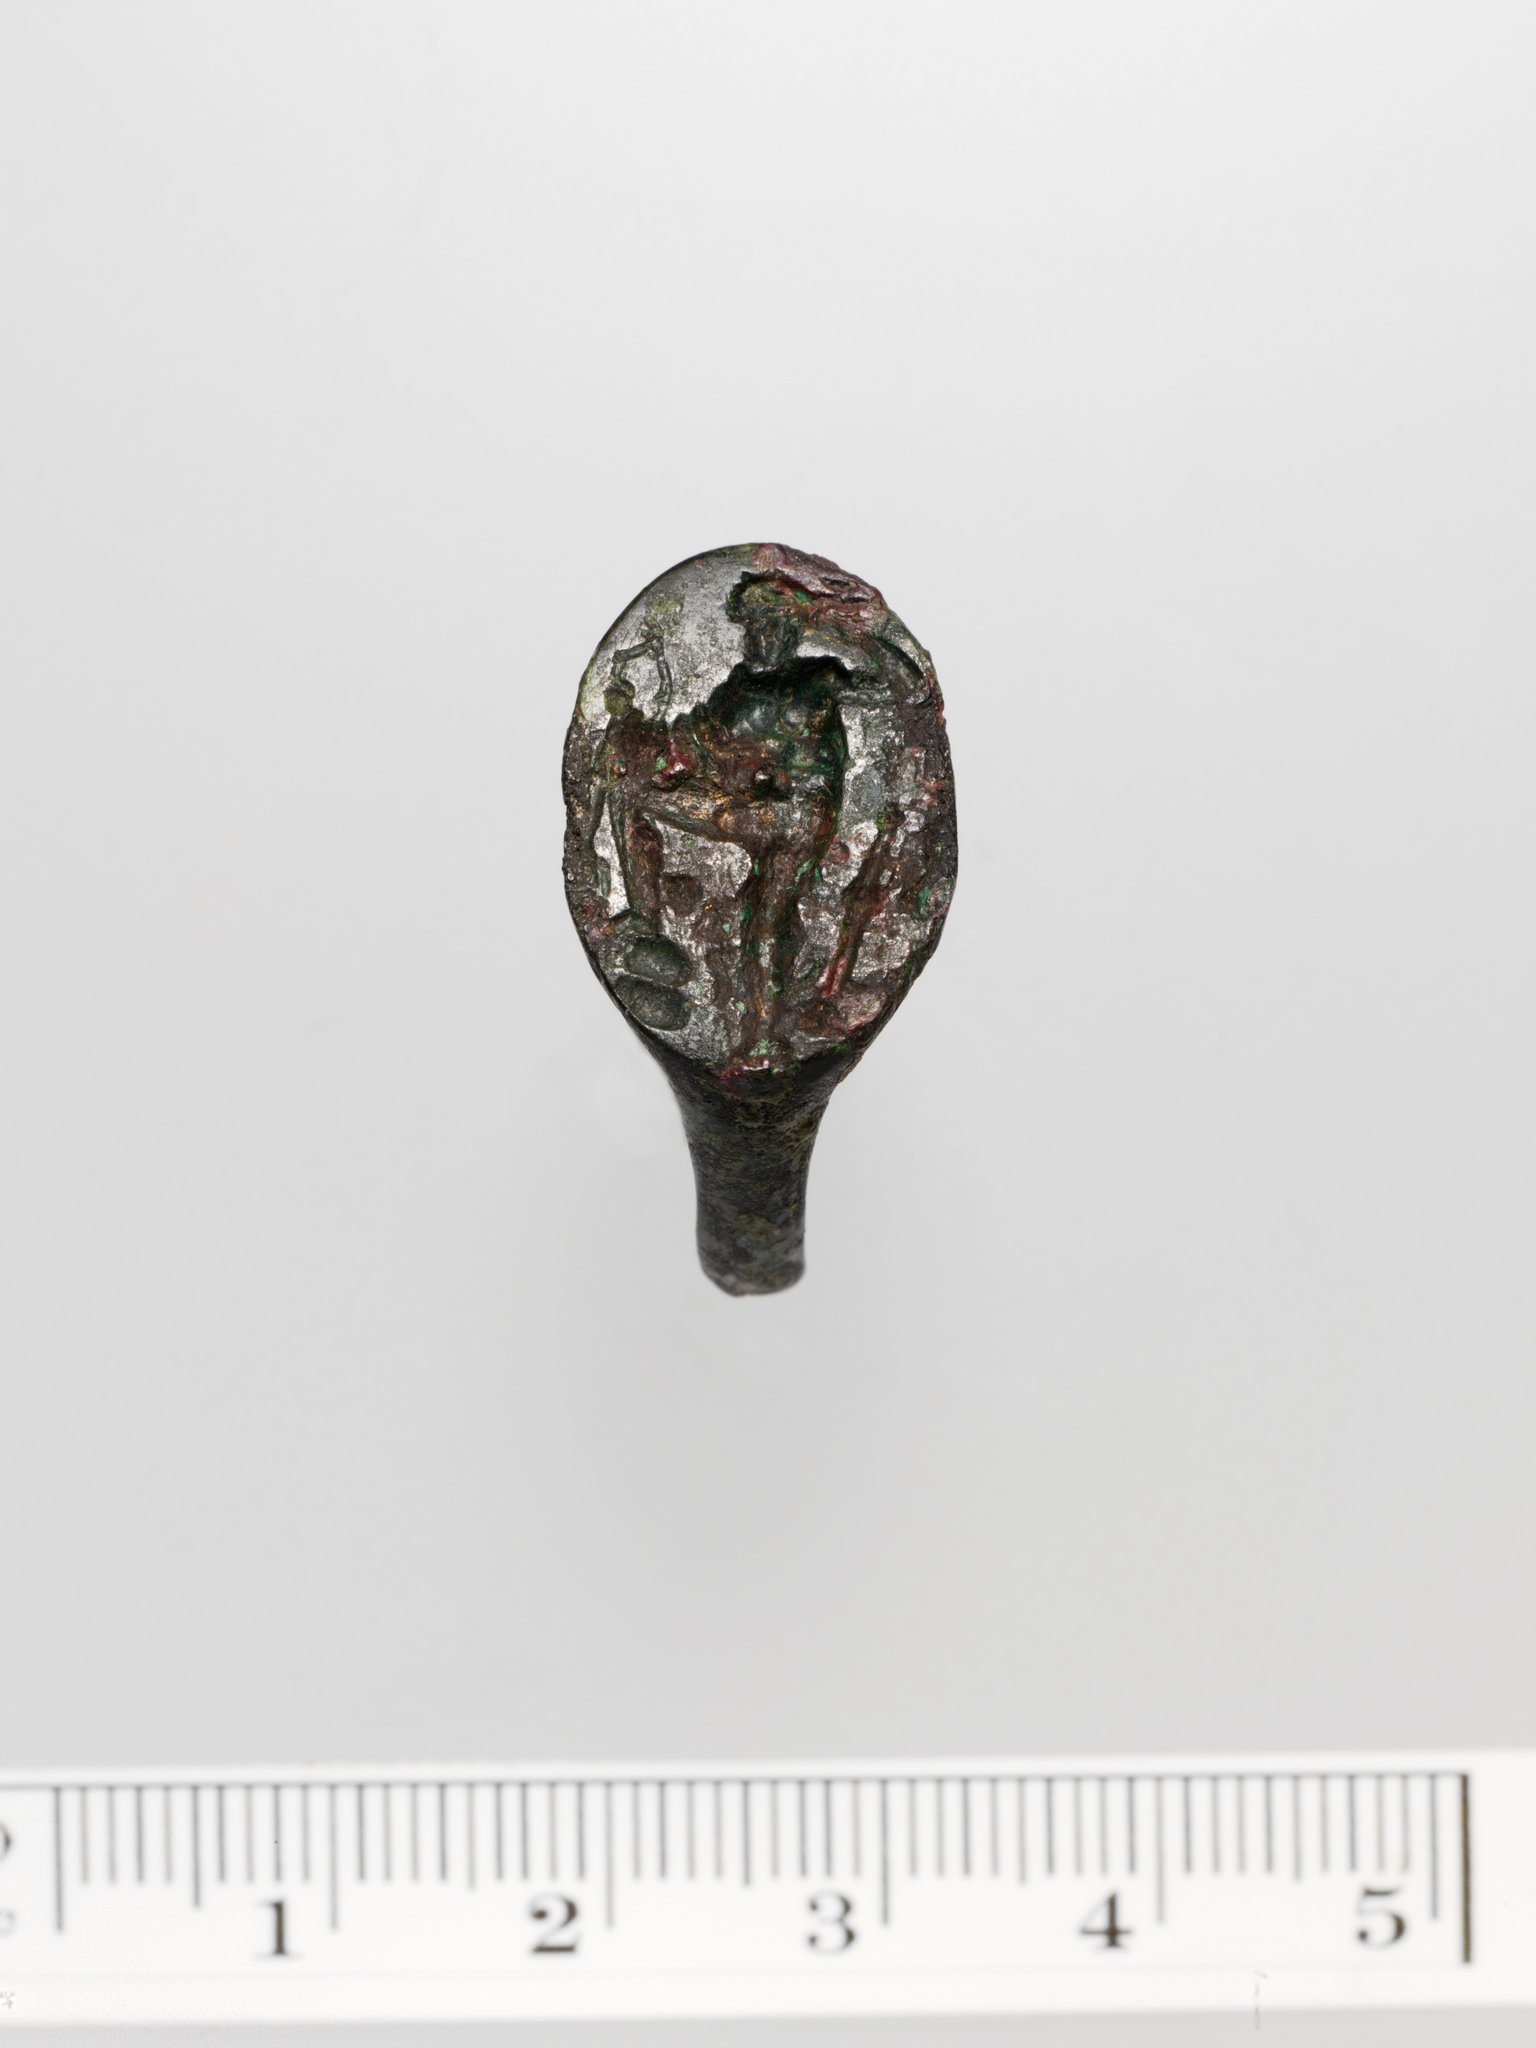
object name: ring with herakles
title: Bronze ring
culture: greek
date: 434-301 BCE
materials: bronze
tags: herakles